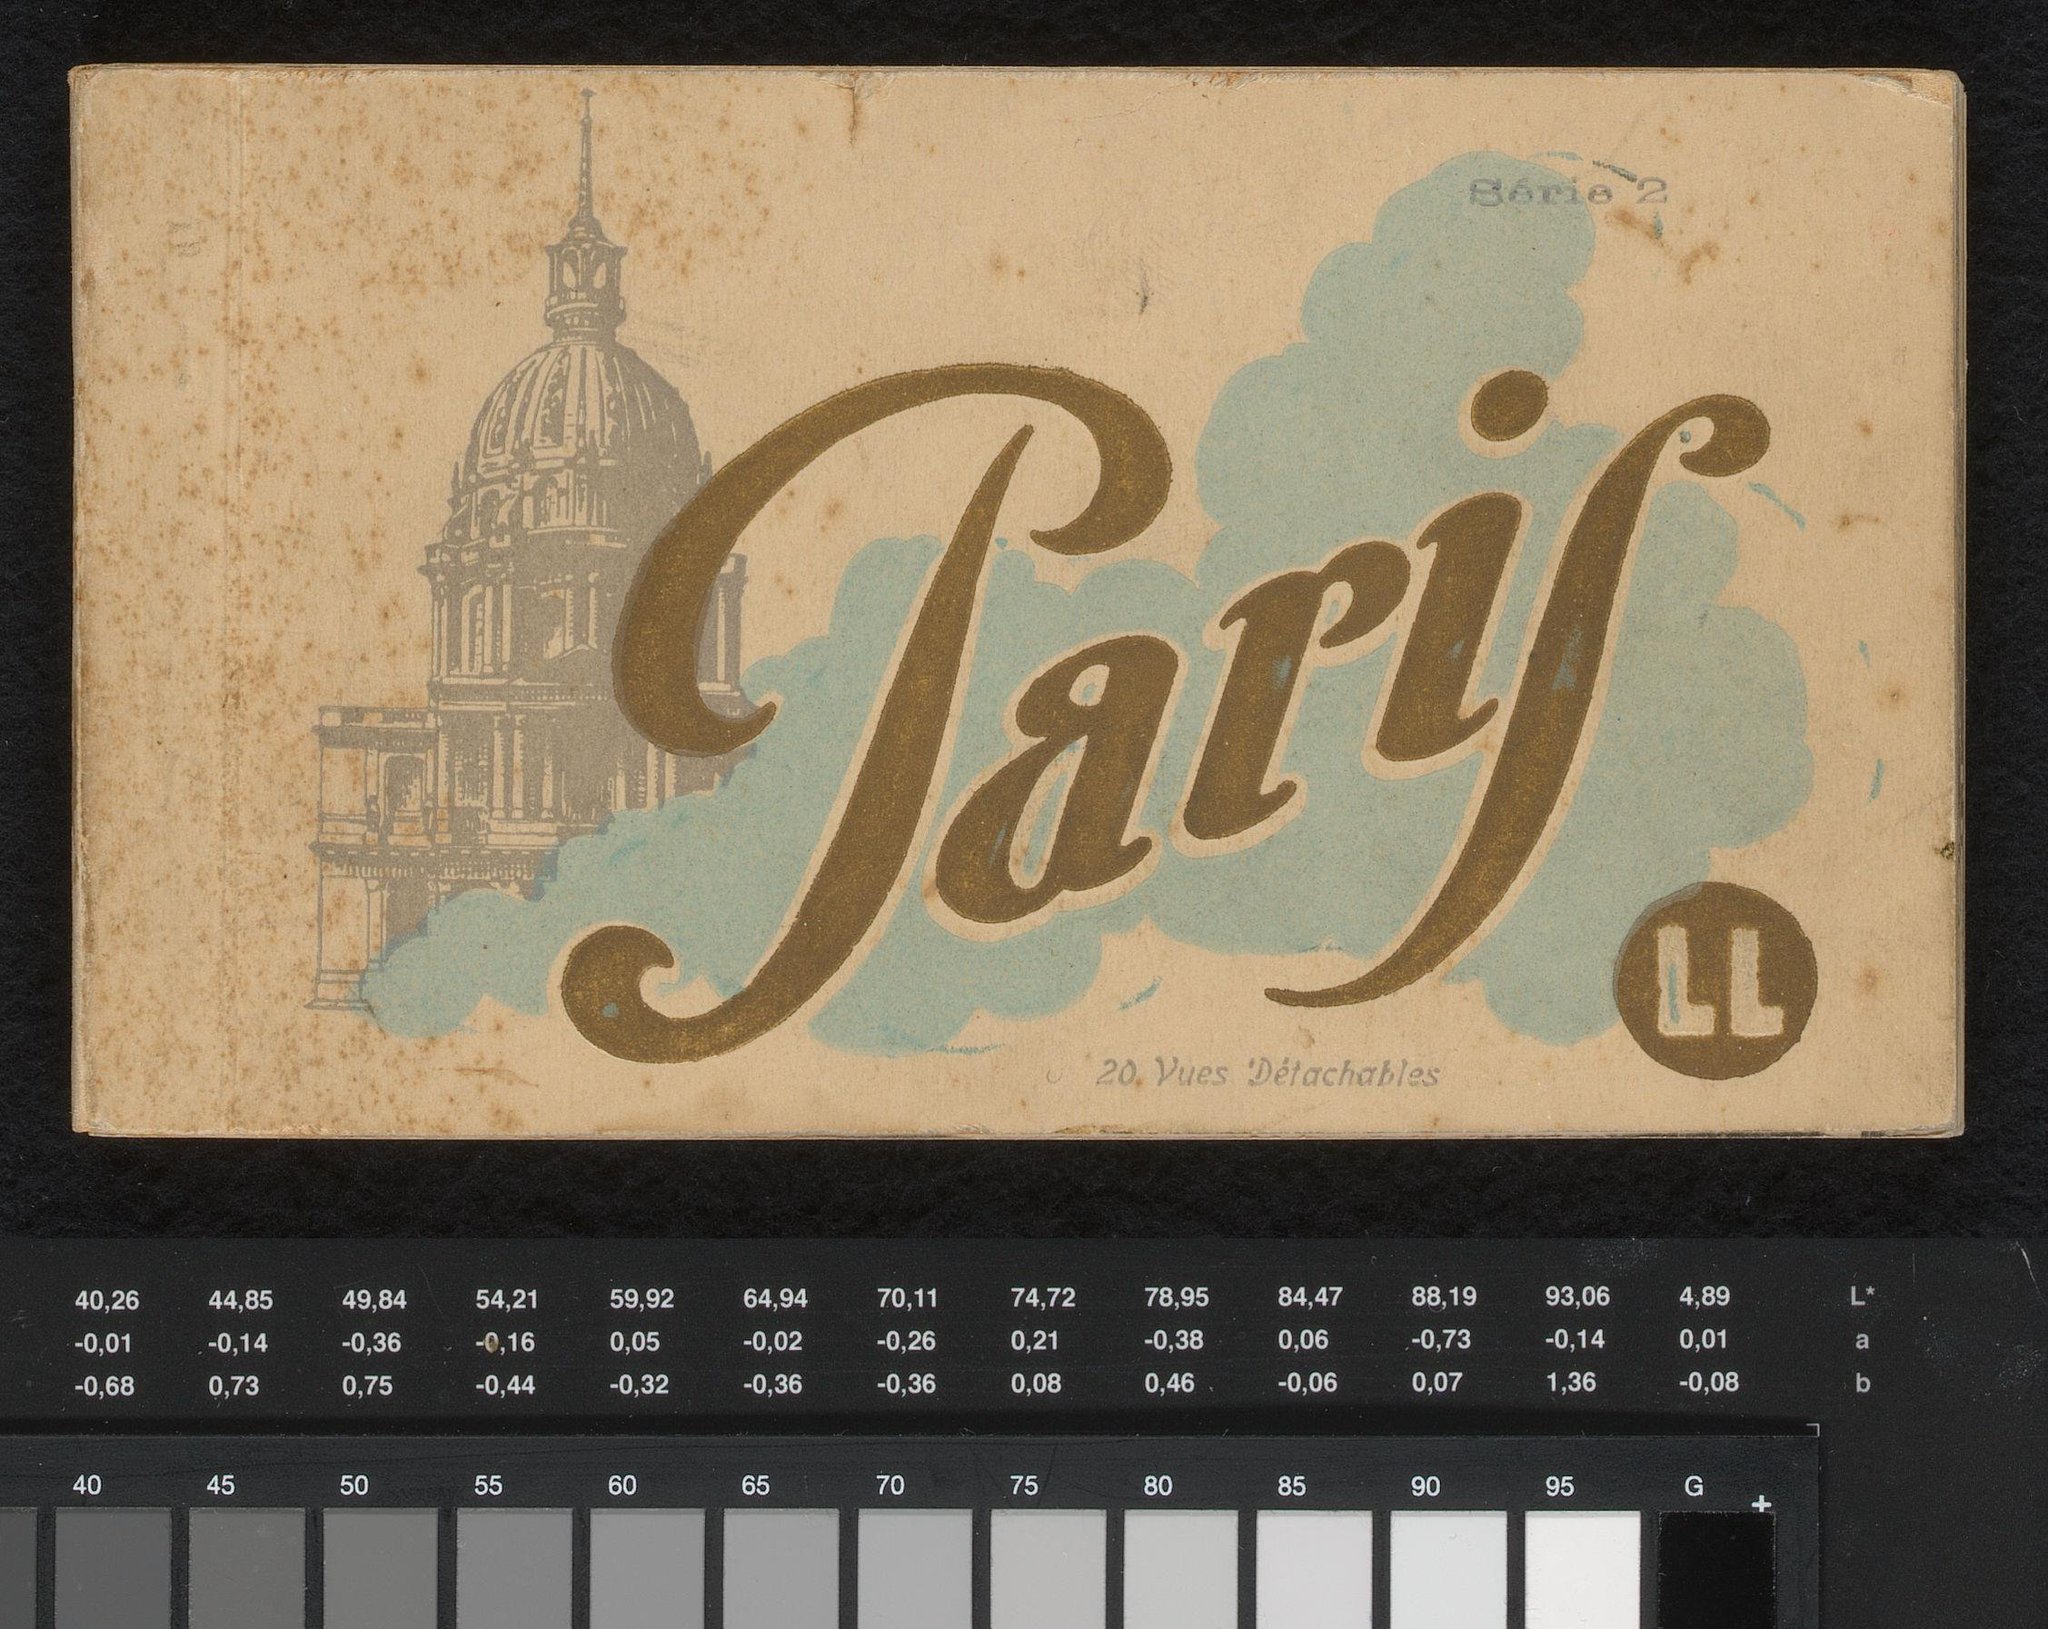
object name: album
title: Paris. 20 vues détachables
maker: Anonymous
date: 1920-1932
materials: cardboard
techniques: blind stamped, photograph, letterpress printing, printing block, stapling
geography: paris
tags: city-view, and landscape with man-made constructions, dome ~ architecture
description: Album met dertien prentbriefkaarten van Parijs. De prentbriefkaarten kunnen eruit gescheurd worden. De prentbriefkaarten zijn aan elkaar geniet, maar losgeraakt van het omslag waarin ze oorspronkelijk zaten vastgelijmd.